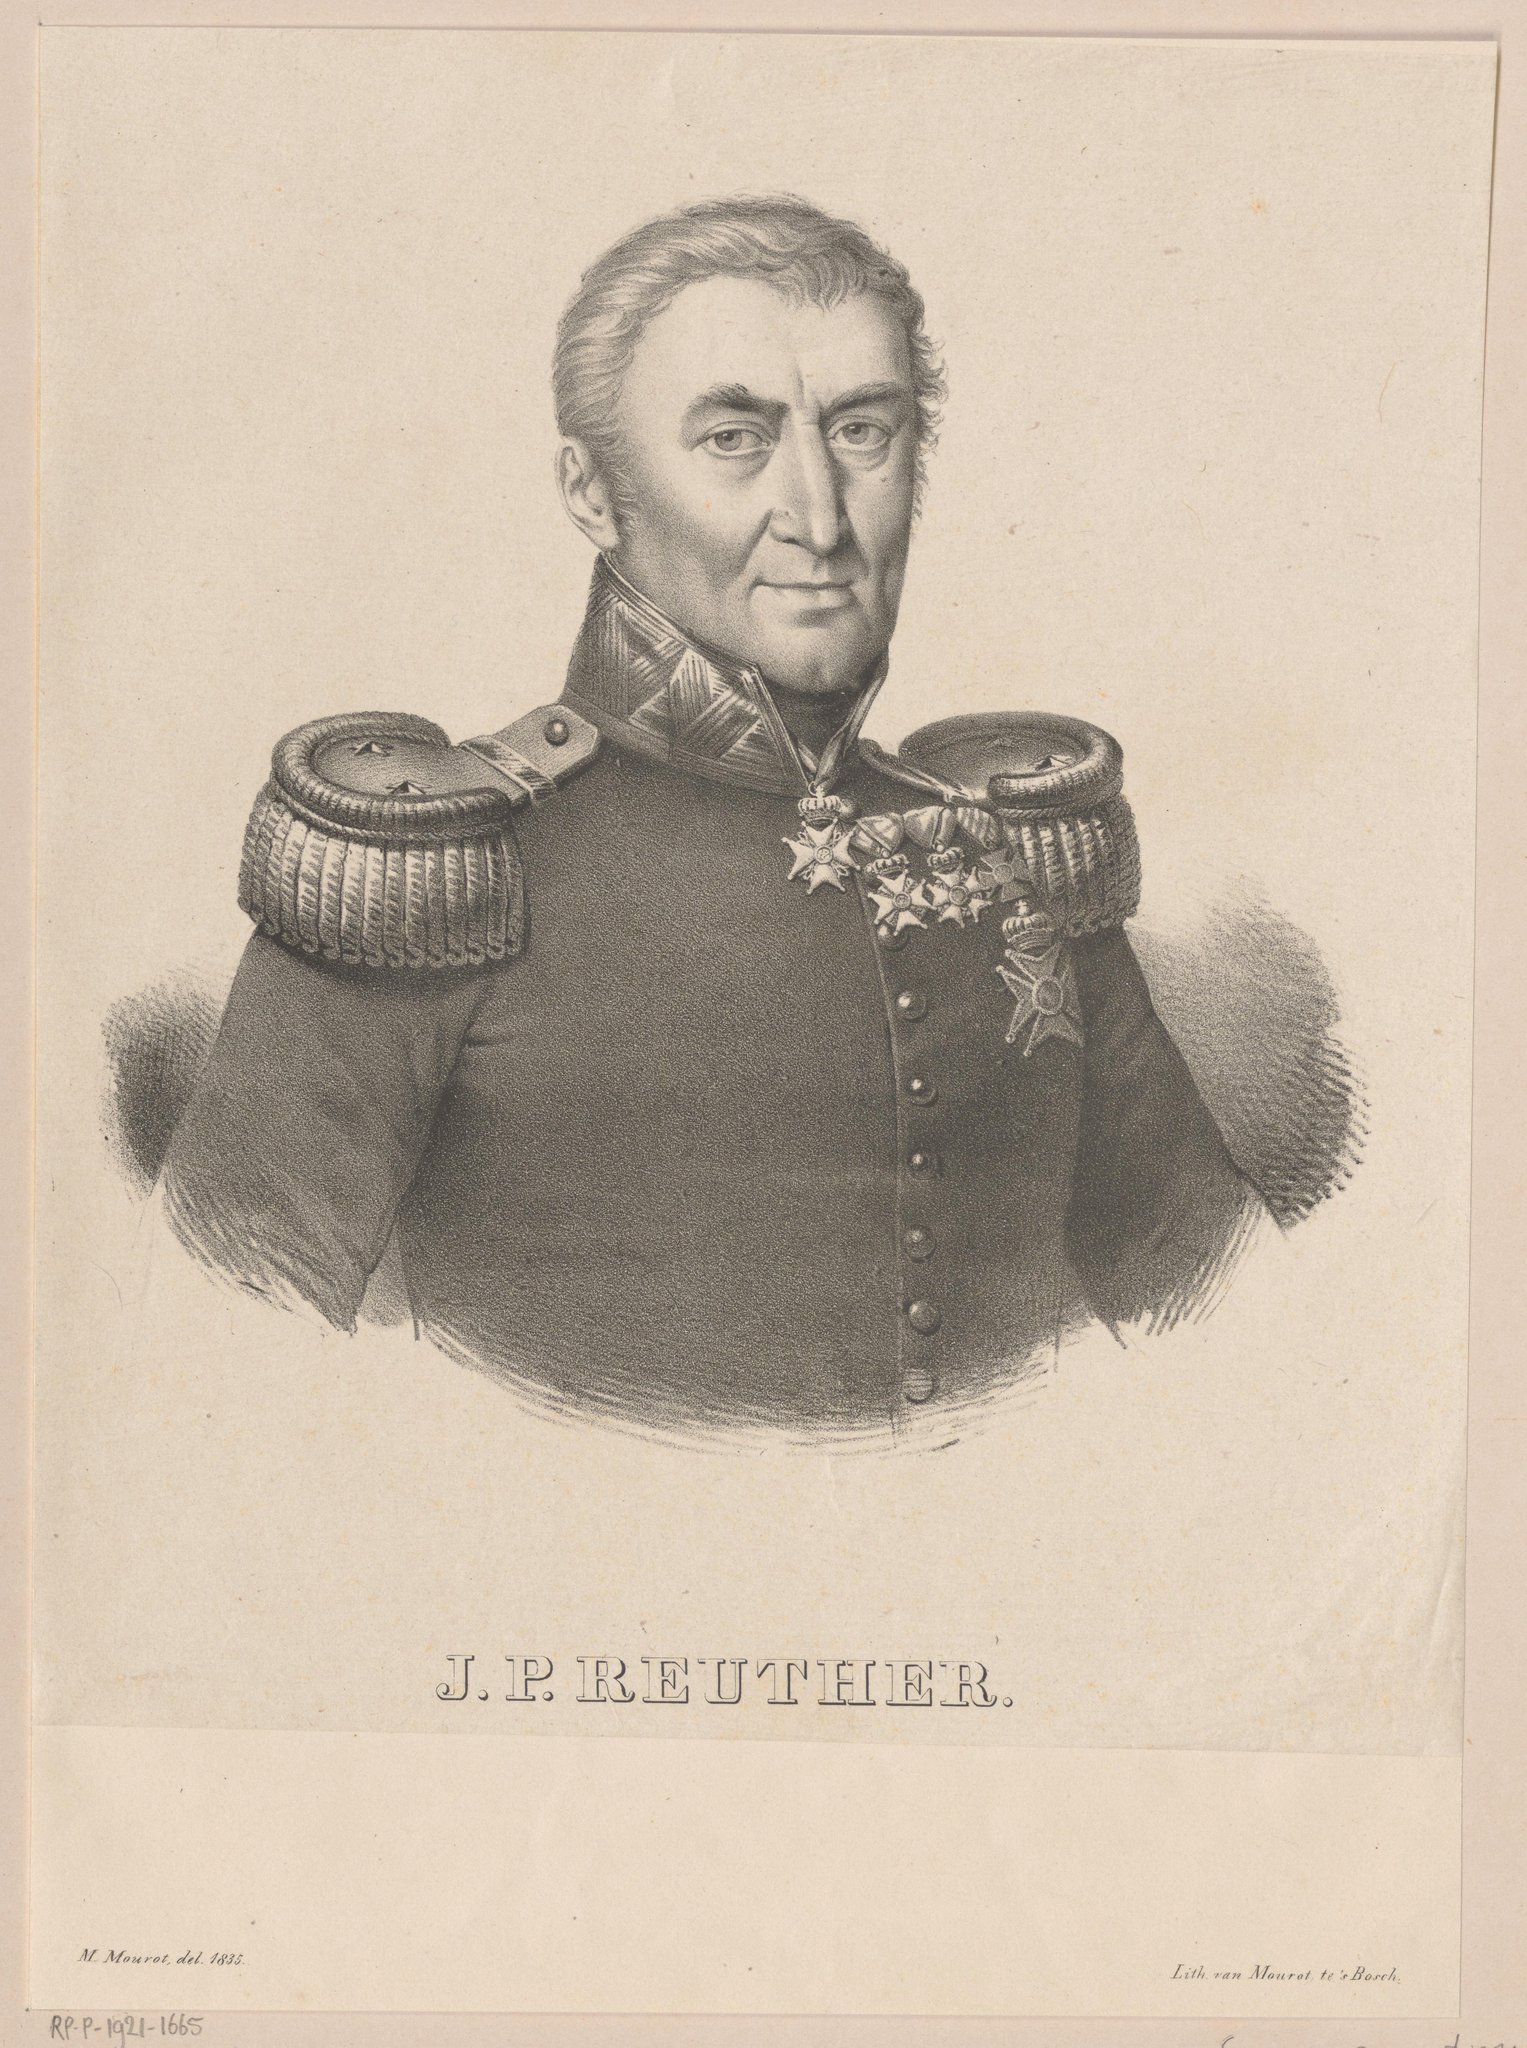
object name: print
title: Portret van Jan Pieter Reuther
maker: michel mourot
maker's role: draughtsman, print maker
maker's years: 1803-1847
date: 1835-1847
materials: paper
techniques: lithograph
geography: den bosch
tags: the hague, historical persons, medals and other marks of military honour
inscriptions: collector's mark: Lugt 2233